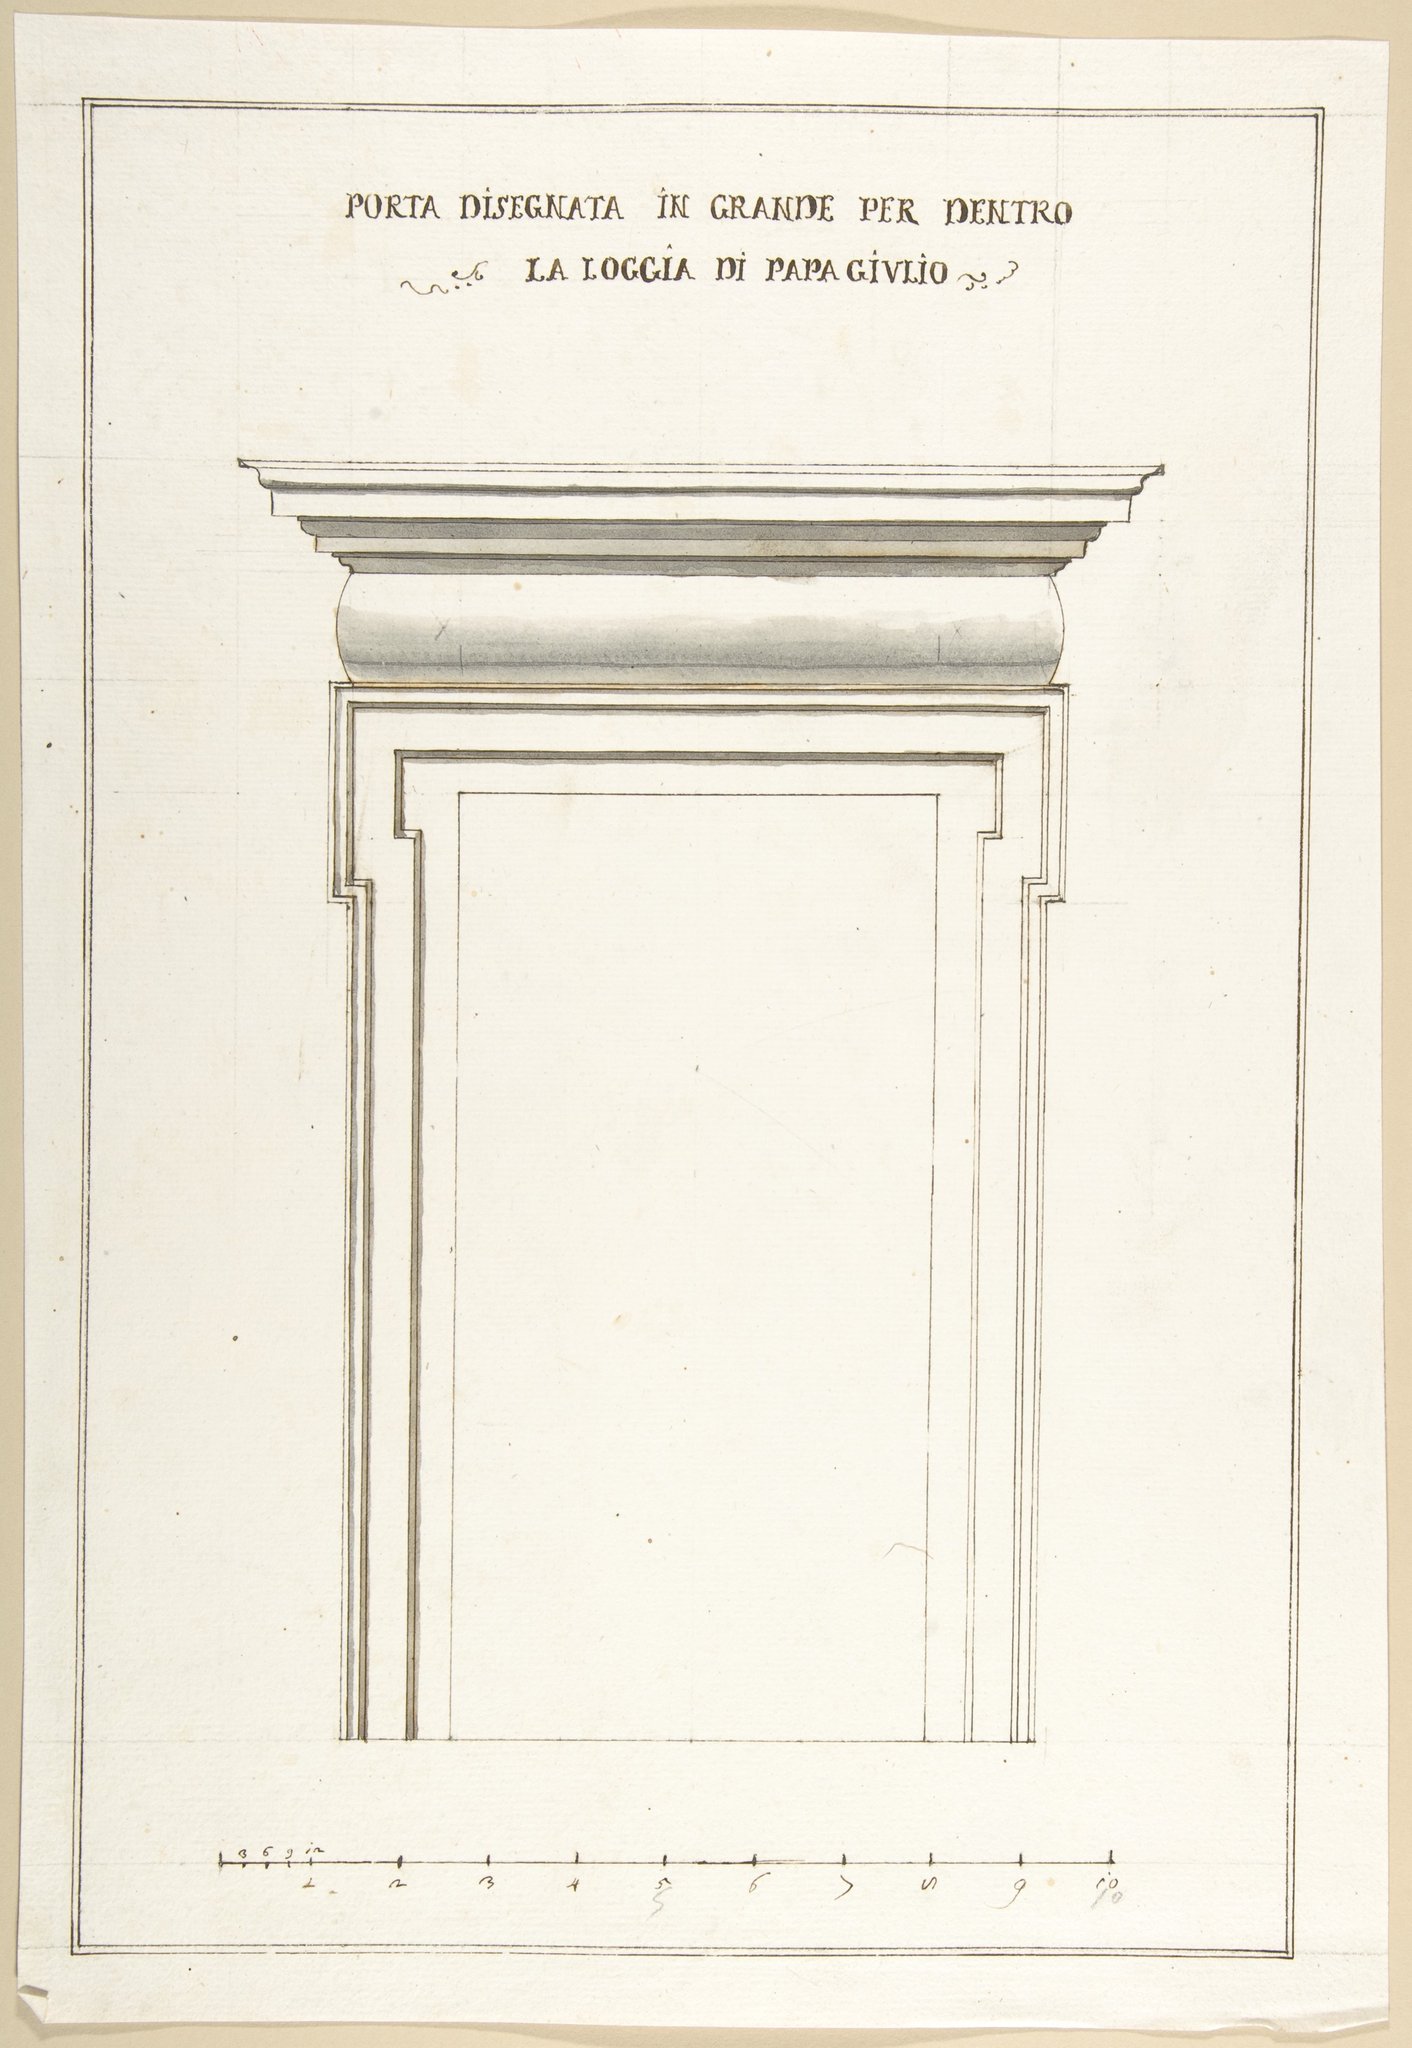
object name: drawing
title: Design Elevation for an Interior Door in the Loggia of Pope Julius [III.]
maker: pietro paolo coccetti (cocchetti)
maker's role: artist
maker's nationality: italian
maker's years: 1710-1727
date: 1710-1727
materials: graphite, ink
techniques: brush, pen, wash